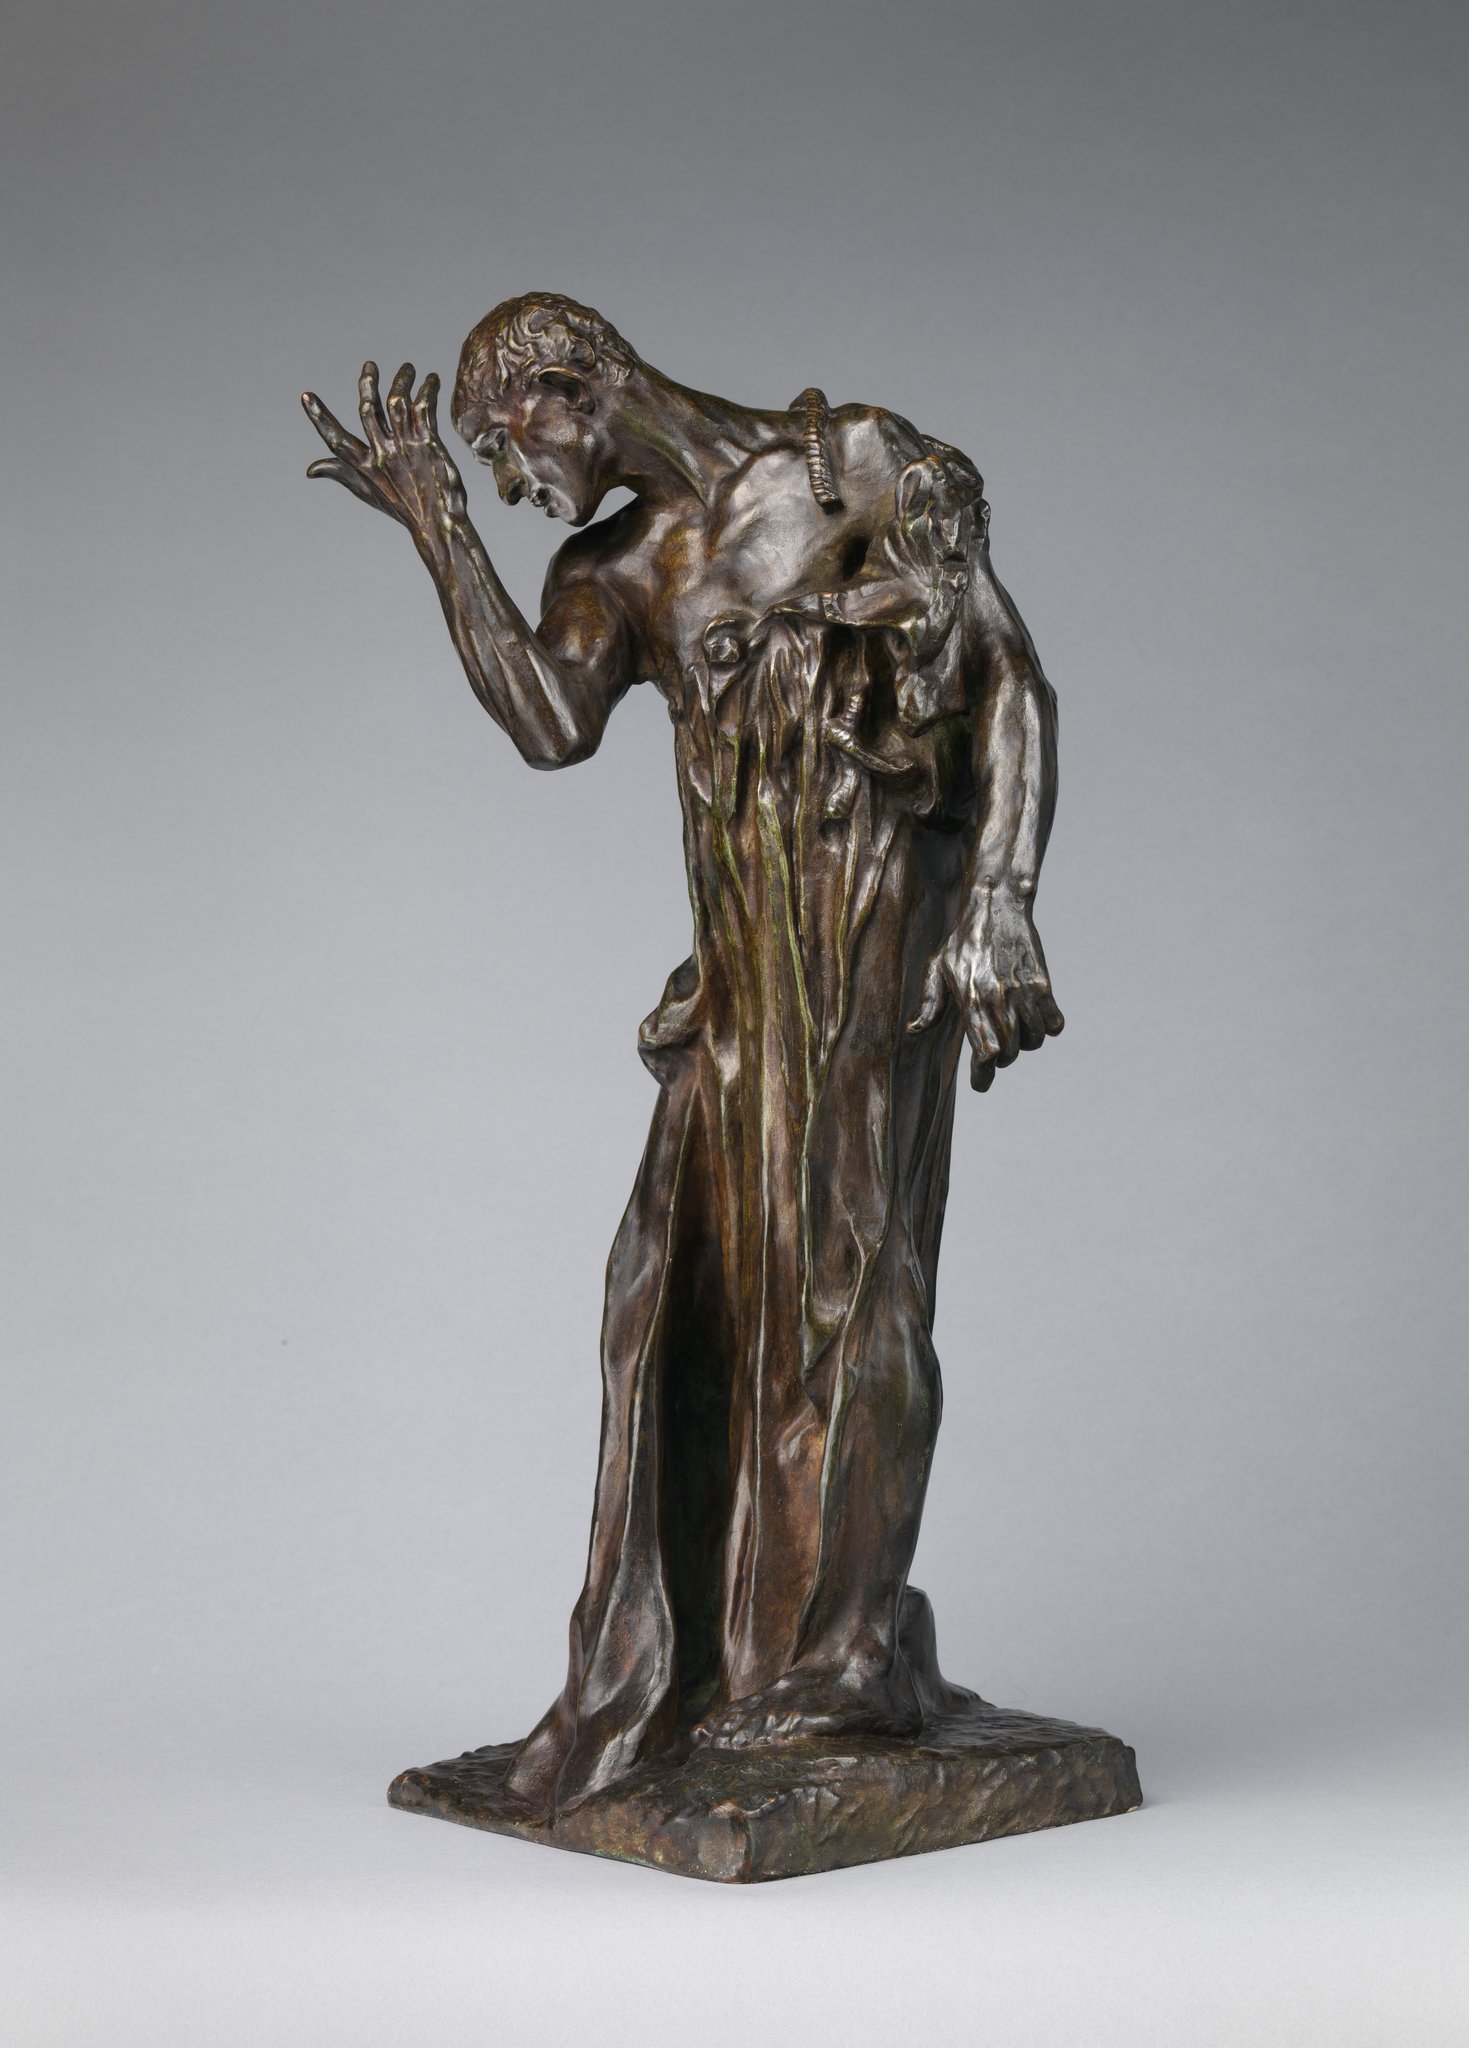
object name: statuette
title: Pierre de Wiessant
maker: auguste rodin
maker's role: artist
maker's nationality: french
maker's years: 1840-1917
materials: bronze, patina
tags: men